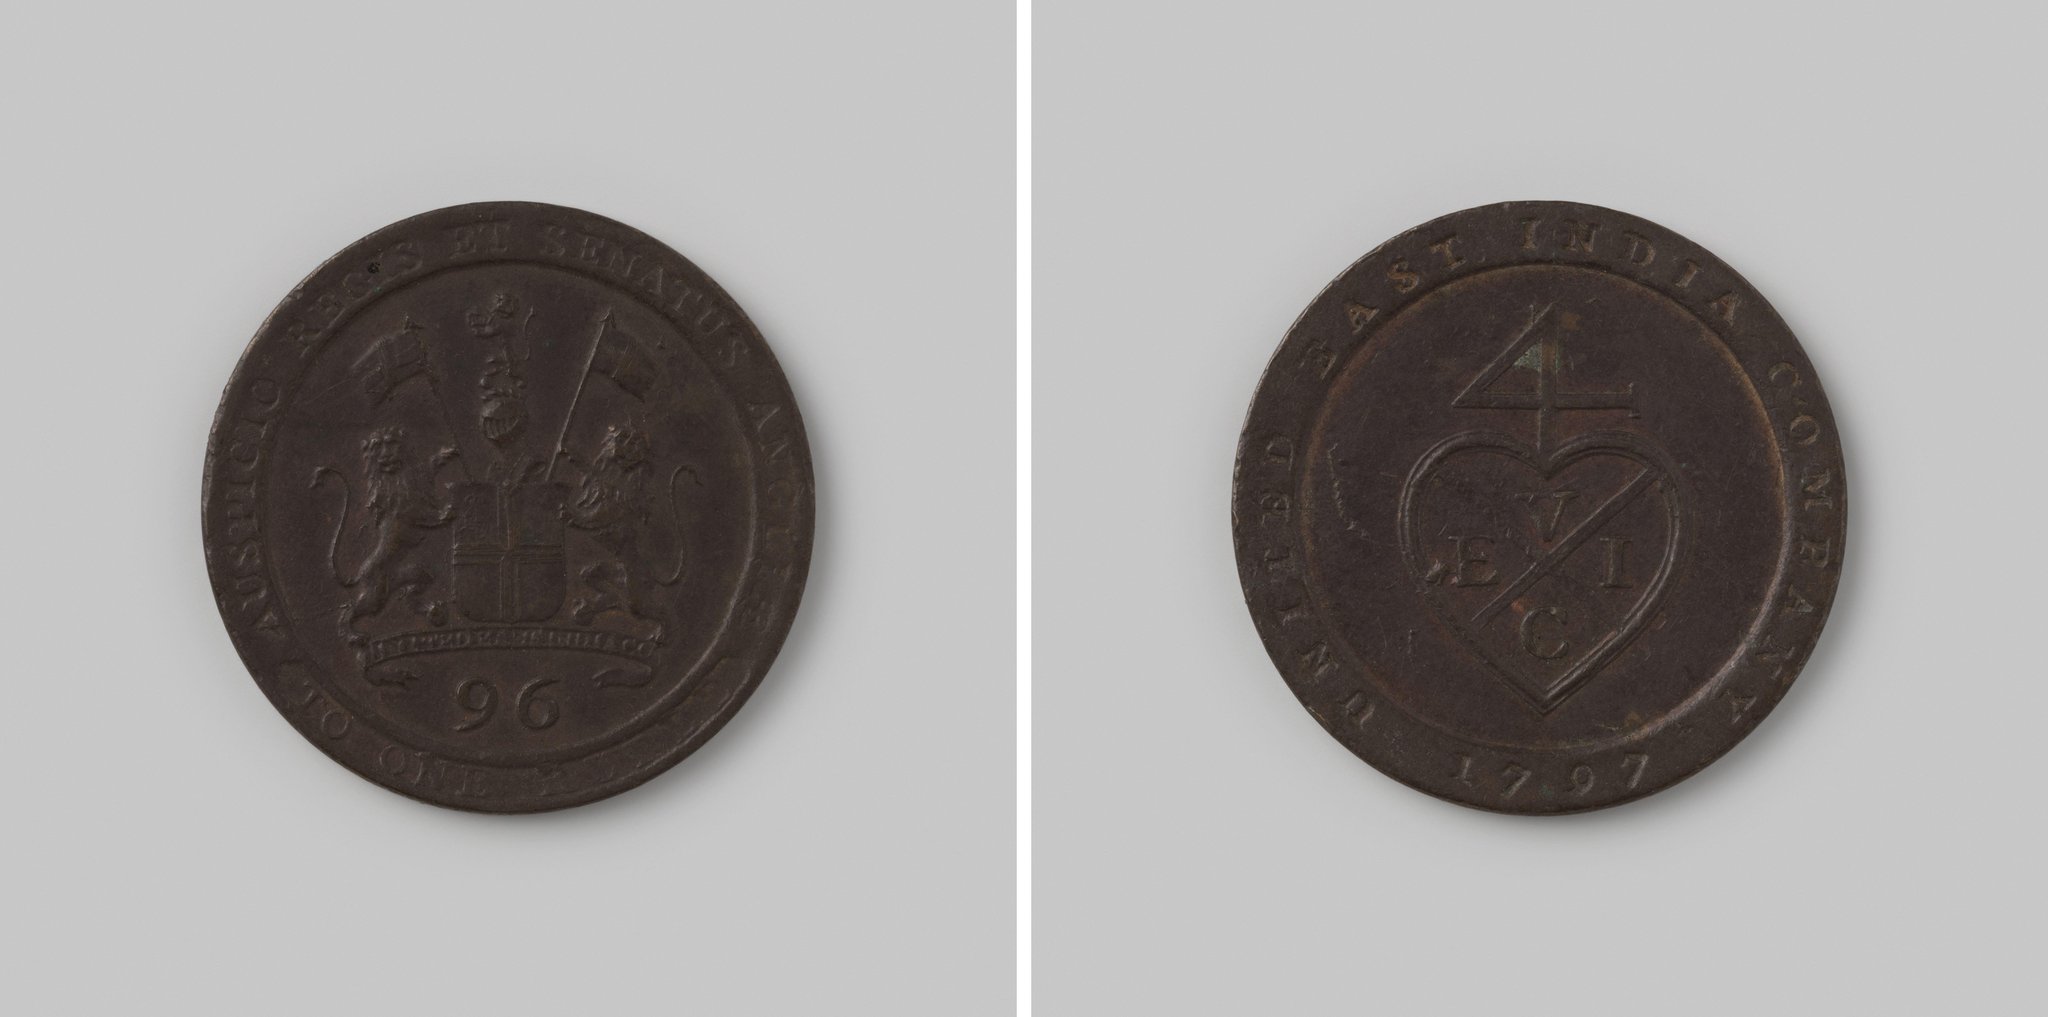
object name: coin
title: Engelse Oostindische Compagnie (EIC), Northern Circars, Madras, India, 1/96 roepie,1797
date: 1797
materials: copper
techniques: striking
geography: birmingham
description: Koperen munt. Voorzijde: door twee op banderol, waarin opschrift, staande leeuwen met pijl, waaraan vlag, in de klauw, gehouden wapenschild van de EIC, waarboven helmteken. Daaronder in twee regels waarde-aanduiding: 96 to one rupee. Keerzijde: monogram van de EIC. Jaartal onderaan in omschrift. Randschrift.